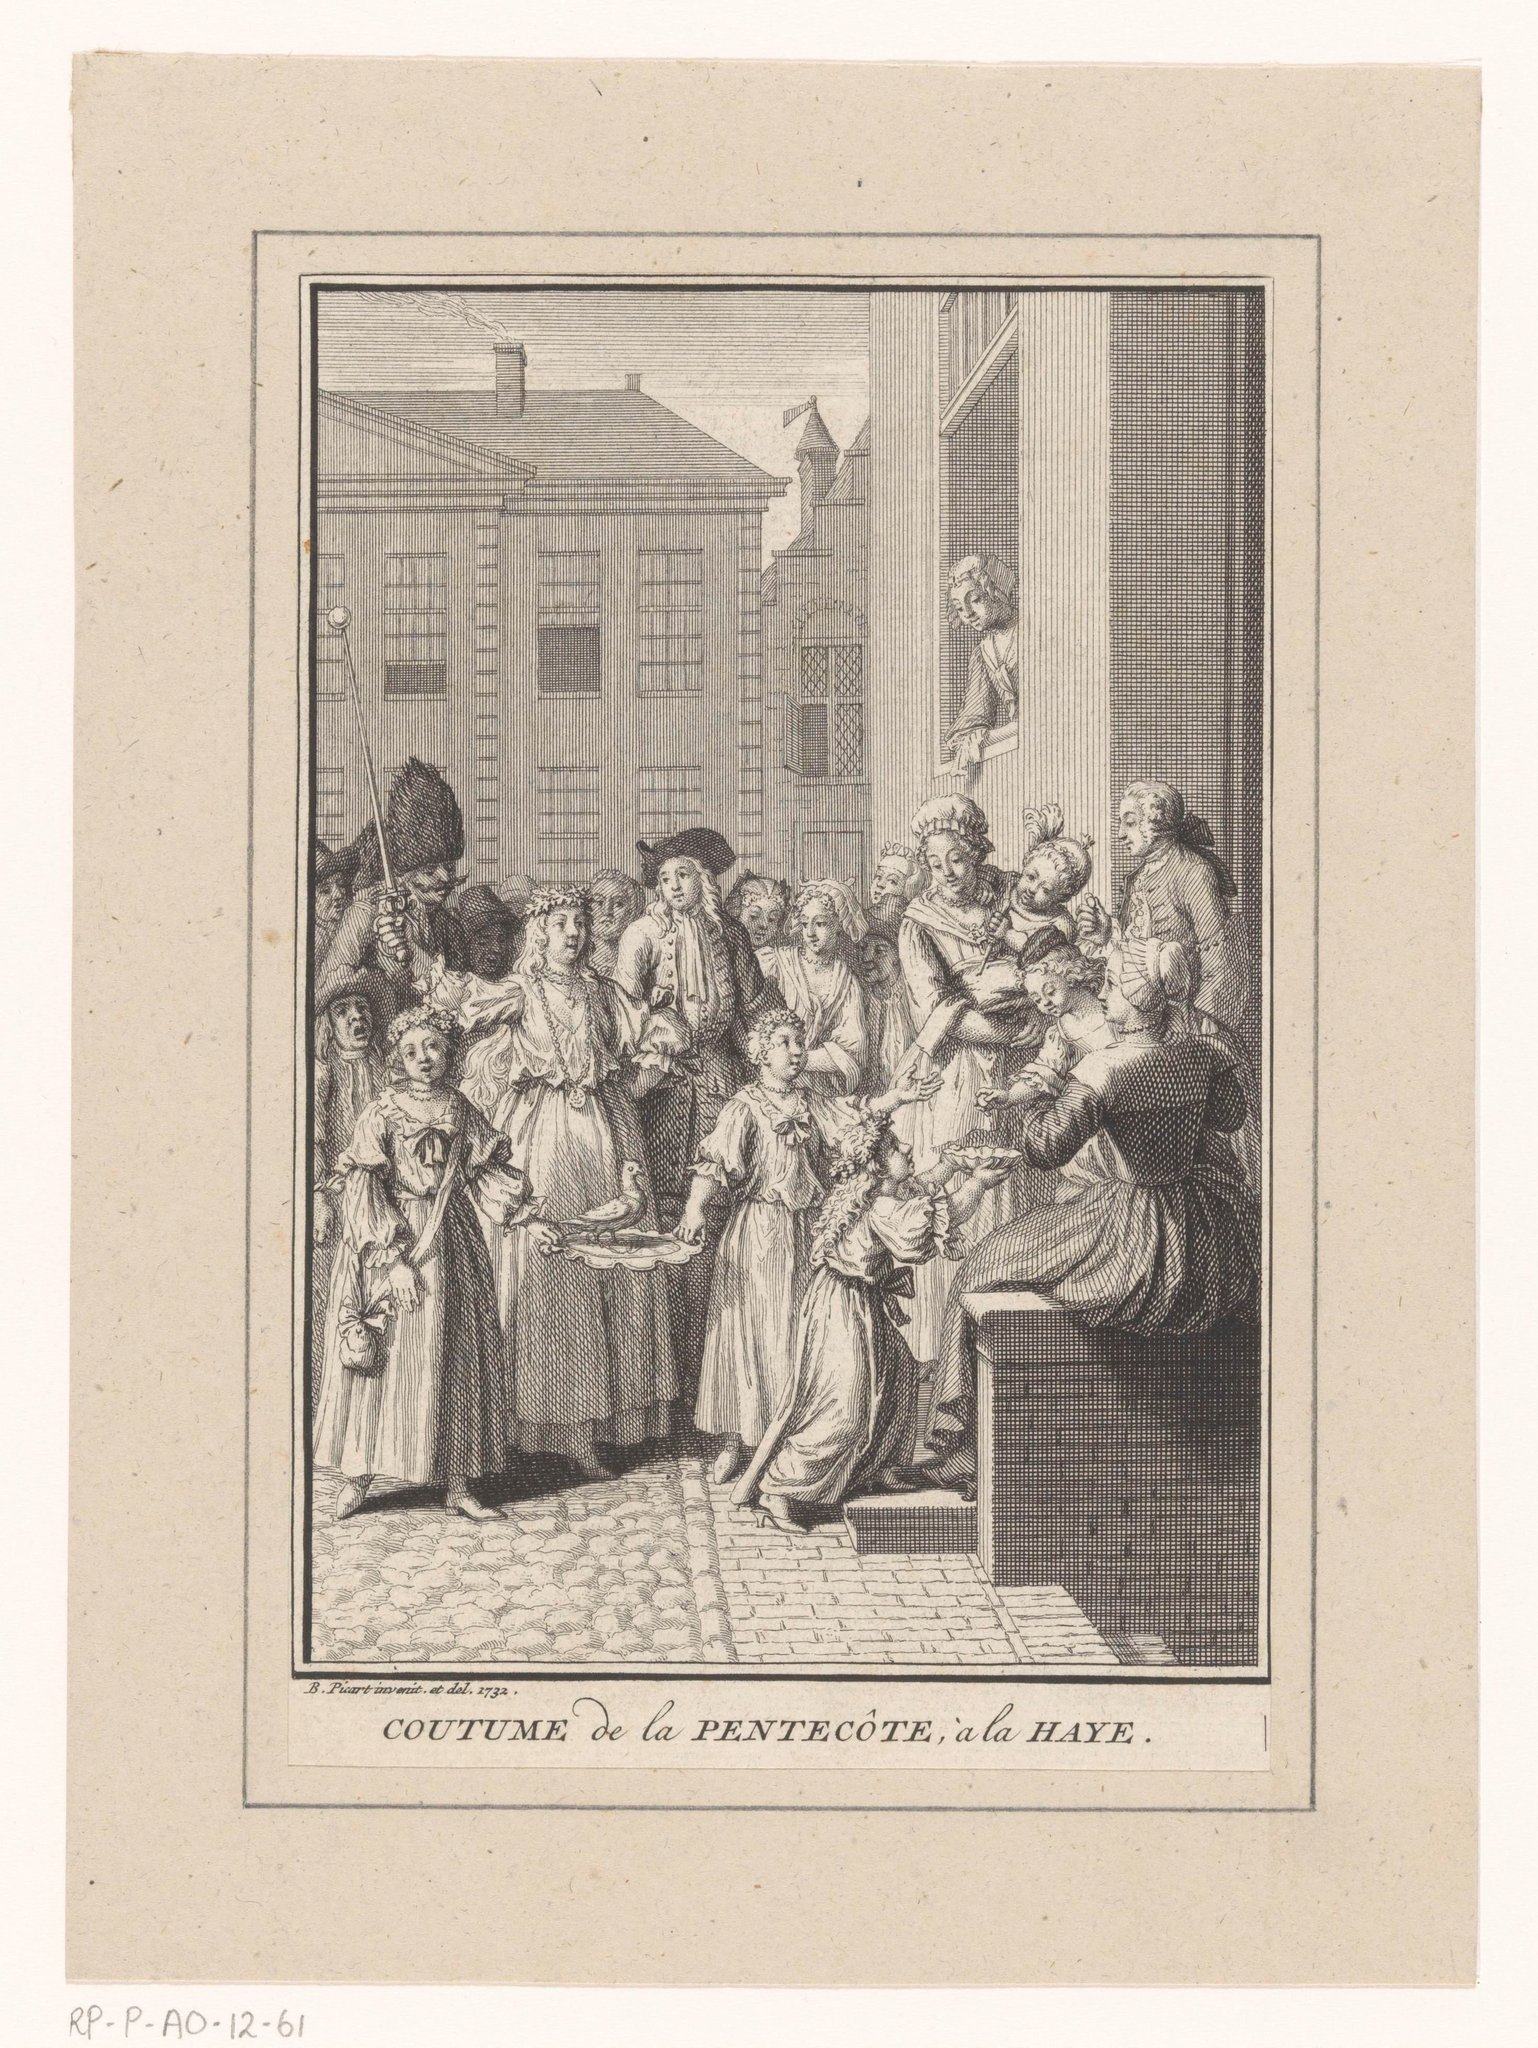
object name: print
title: Coutume de la Pentecôte, à La Haye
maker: bernard picart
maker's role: draughtsman, print maker, publisher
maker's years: 1673-1733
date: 1732-1736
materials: paper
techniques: engraving, etching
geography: amsterdam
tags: pentecost, whitsunday, the hague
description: Deze voorstelling was oorspronkelijk onderdeel van een prent met daarop drie voorstellingen met gebruiken rond Pinksteren en Driekoningen, zie: RP-P-OB-51.712 en RP-P-OB-84.123. Zie ook RP-P-AO-9A-29. De hele prent is ook gebruikt in: Picart, Bernard. Ceremonies et coutumes religieuses de tous les peuples du monde (...). 10 delen. Amsterdam: Jean Frederic Bernard, 1723-1743, deel 3 (1733), na p. 352. En in de Nederlandse vertaling: Picart, Bernard en Abraham Moubach. Naaukeurige beschryving der uitwendige godtsdienst-plichten, kerk-zeden en gewoontens van alle volkeren der waereldt : in een historisch verhaal (...). 6 delen. 's-Gravenhage: Rutgert Christoffel Alberts, 1727-1738, deel 5 (1736), na p. 326. En waarschijnlijk ook in de Engelse vertaling.